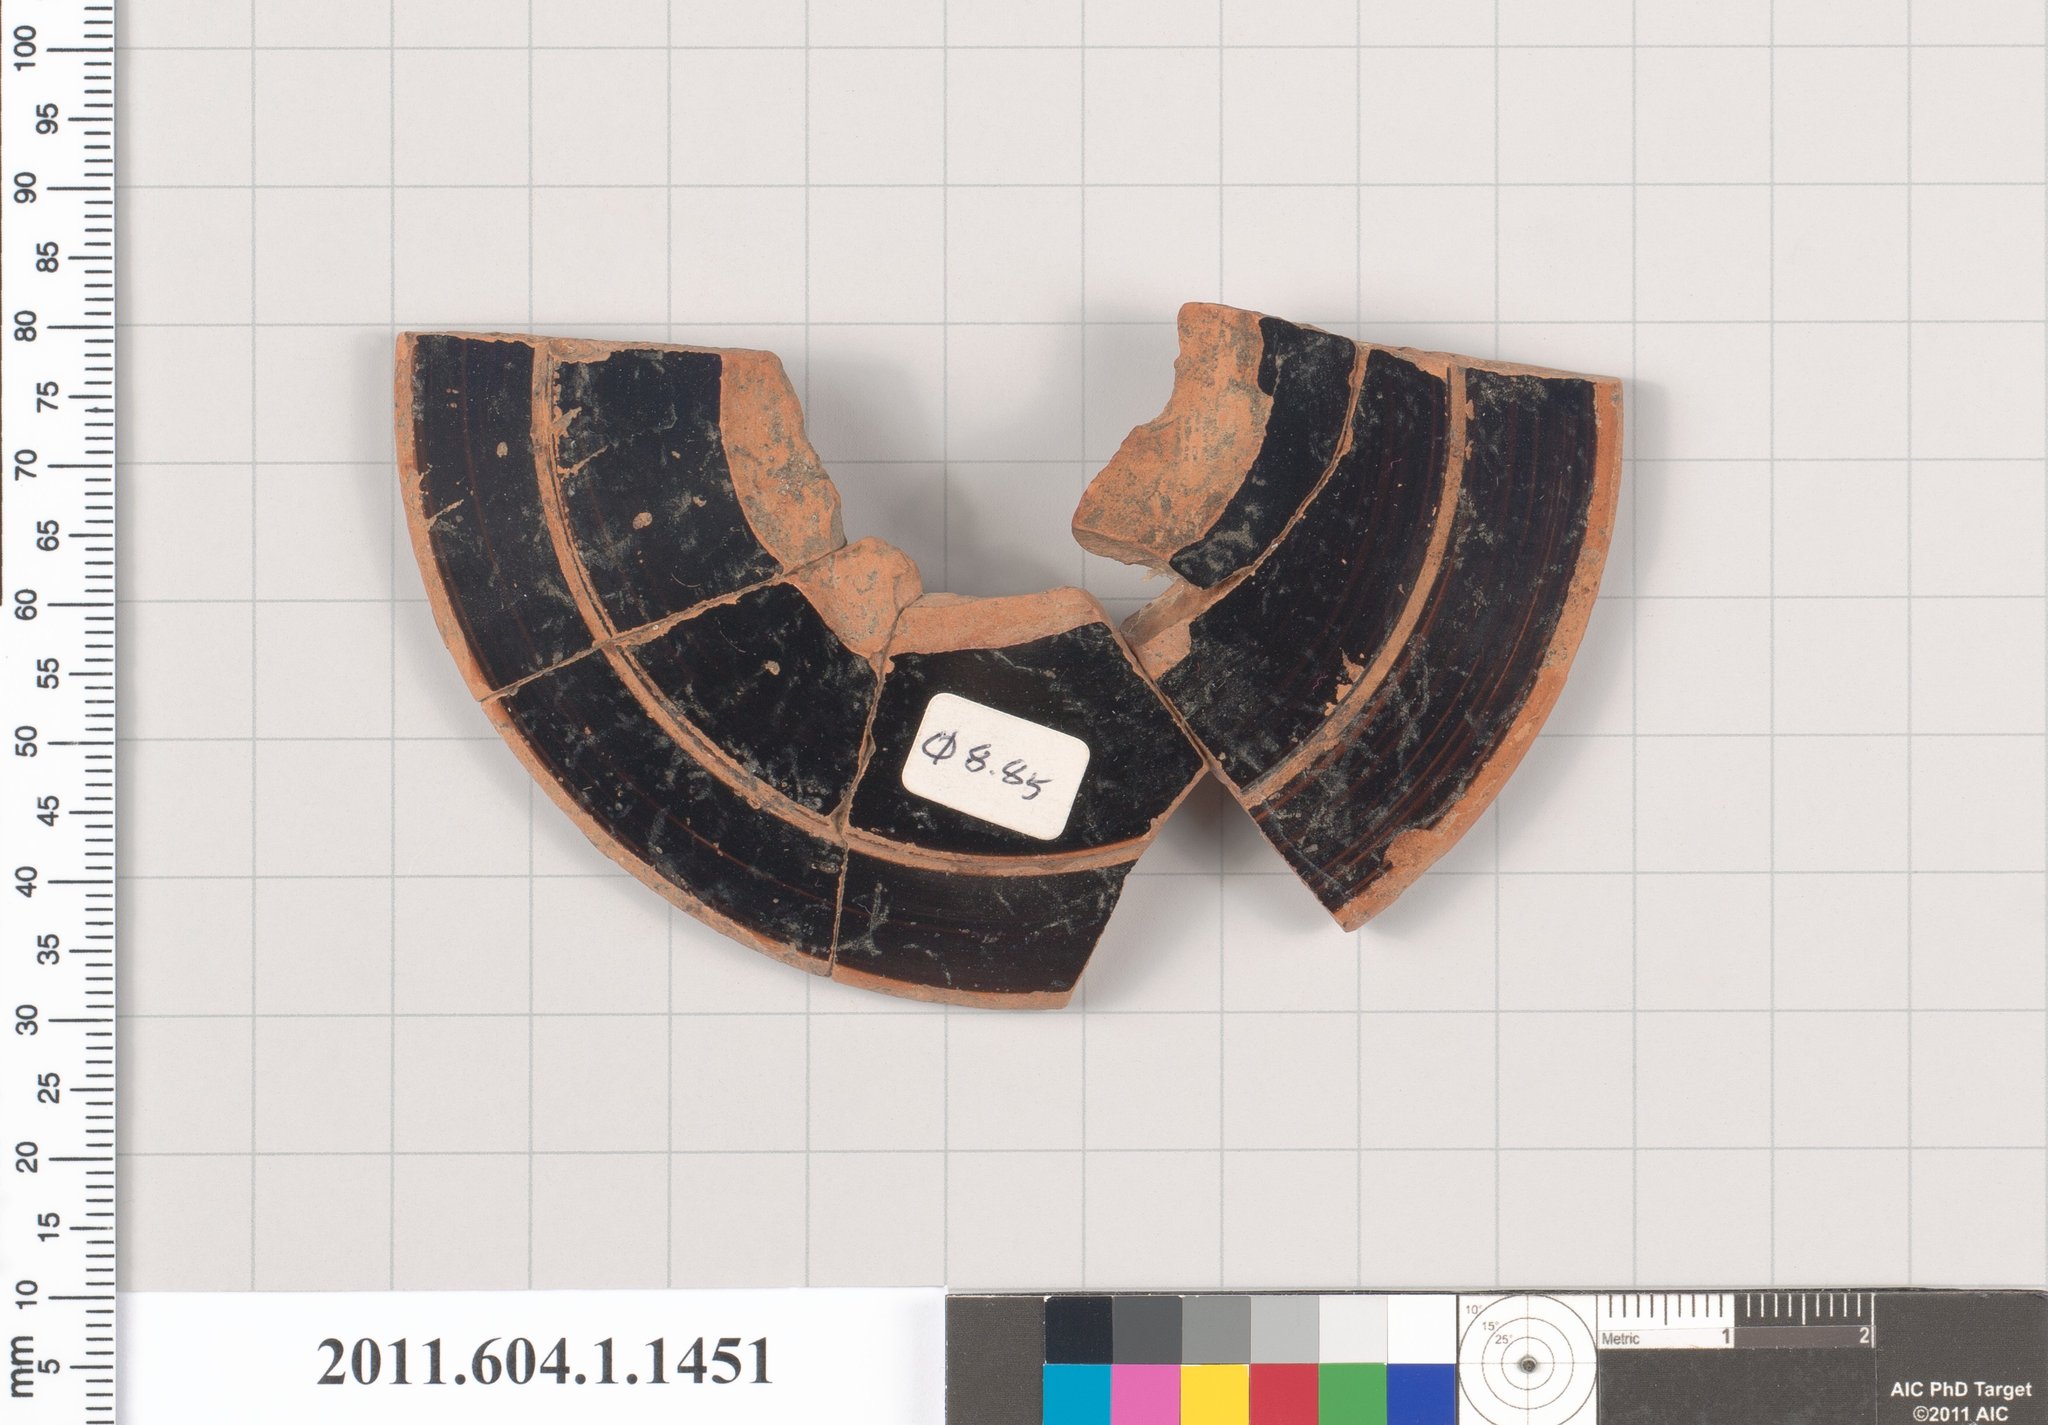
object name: kylix fragment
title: Terracotta fragment of a kylix (drinking cup)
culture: greek, attic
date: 500-401 BCE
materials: terracotta